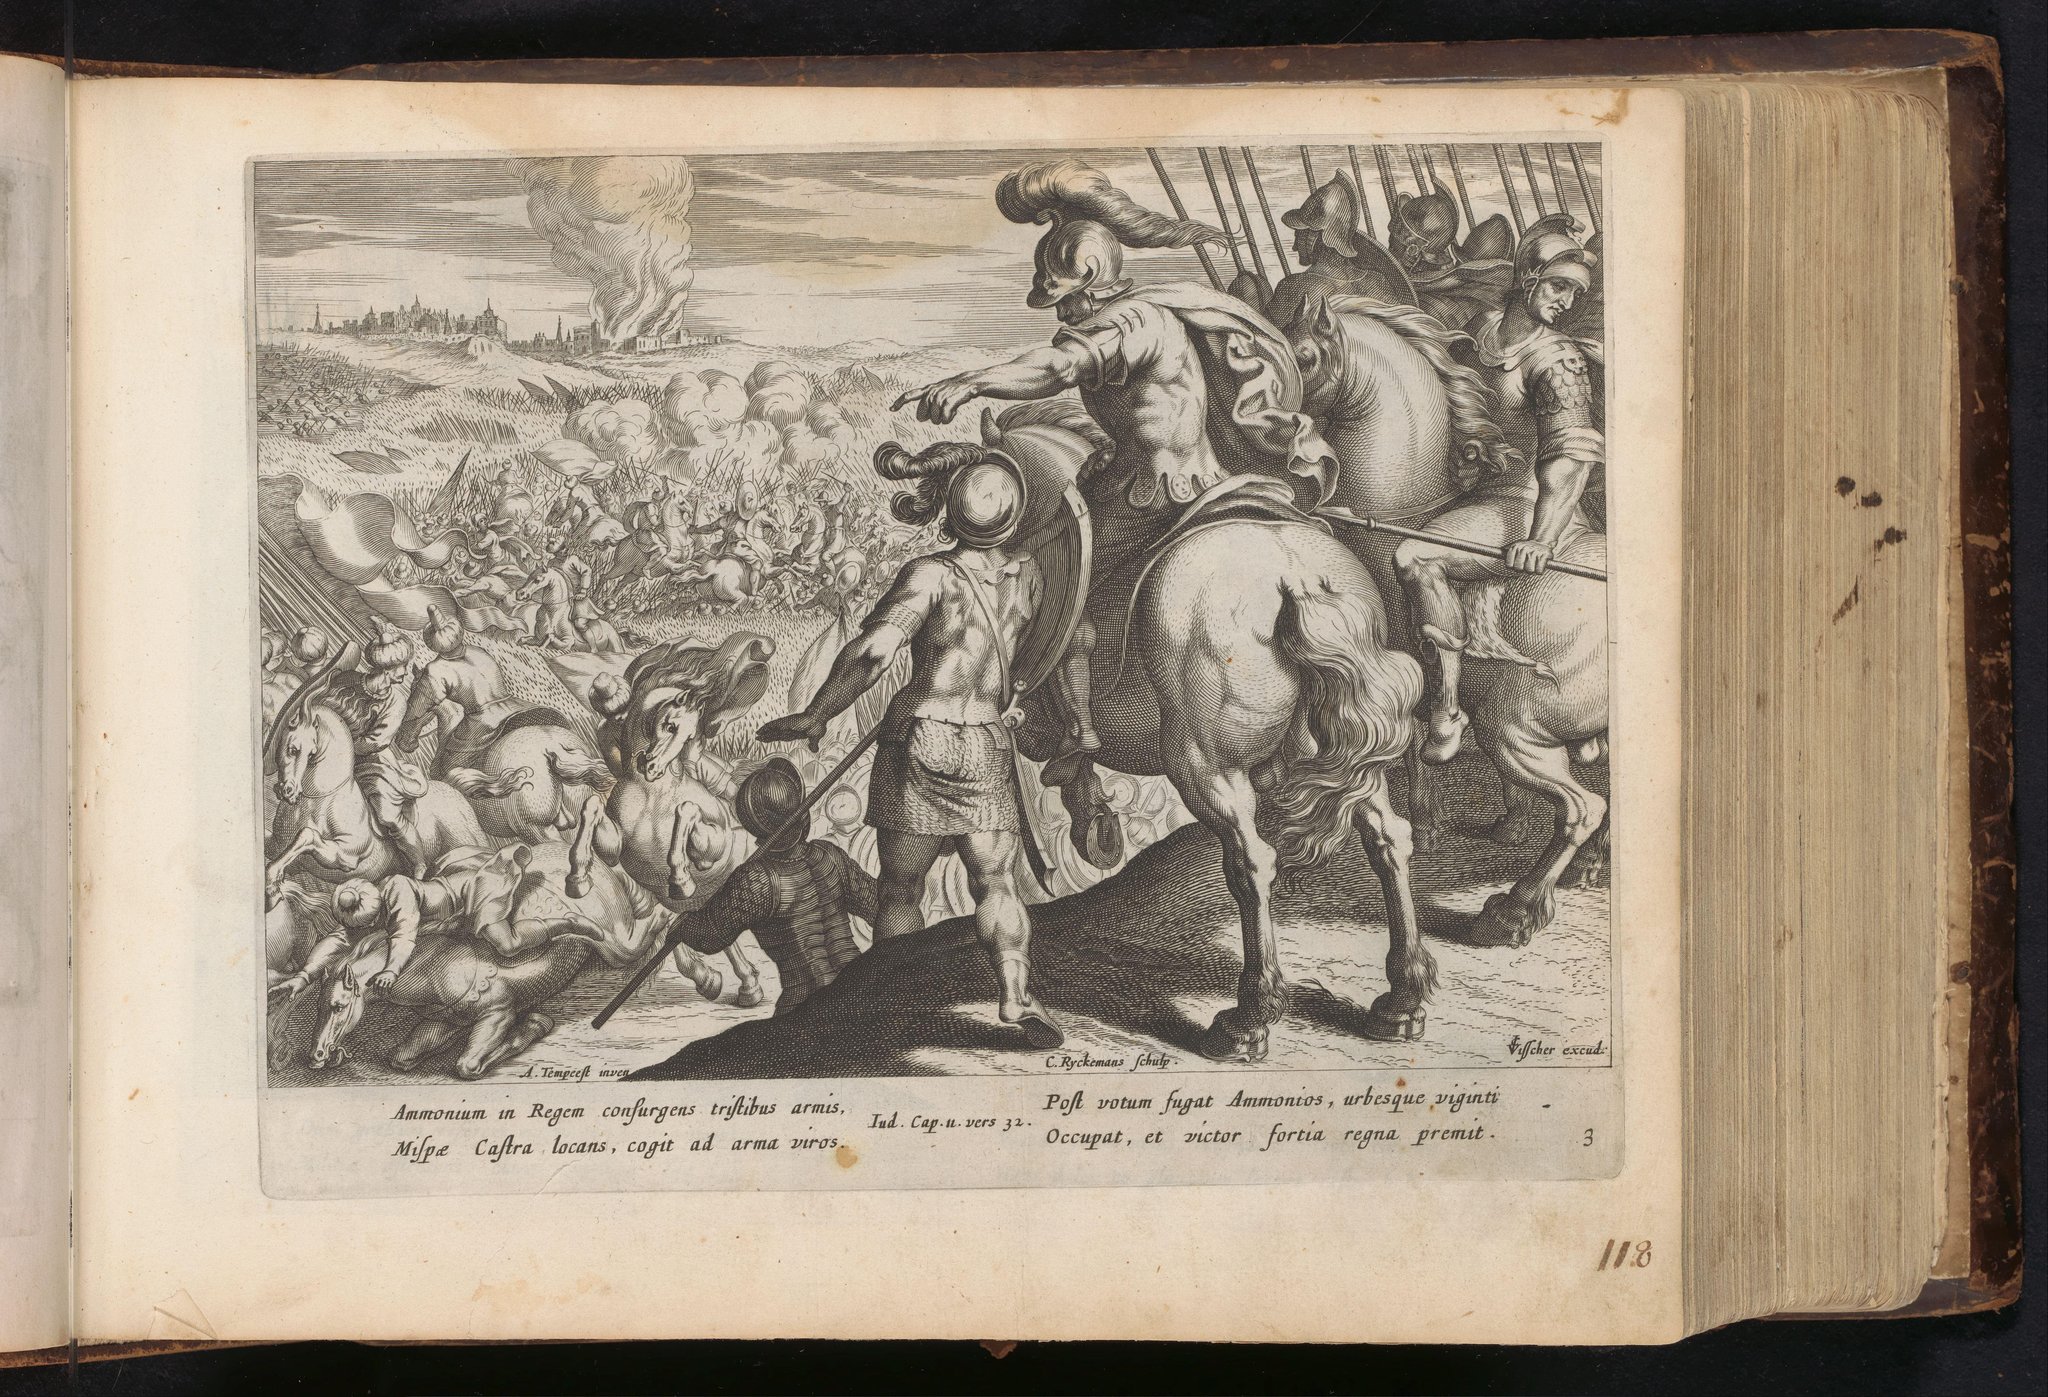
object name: print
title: Geschiedenis van Jefta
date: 1616-1636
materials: paper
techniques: engraving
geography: alkmaar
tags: the ammonites are defeated by jephthah's army; twenty cities are taken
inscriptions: number: ‘118’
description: Jefta en zijn krijgsmacht brengen het leger van de Ammonieten een zware nederlaag toe en nemen twintig steden in. Op de achtergrond het slagveld. Onder de voorstelling een verwijzing in het Latijn naar de Bijbeltekst in Ri. 11:32. Deze prent maakt deel uit van een album.